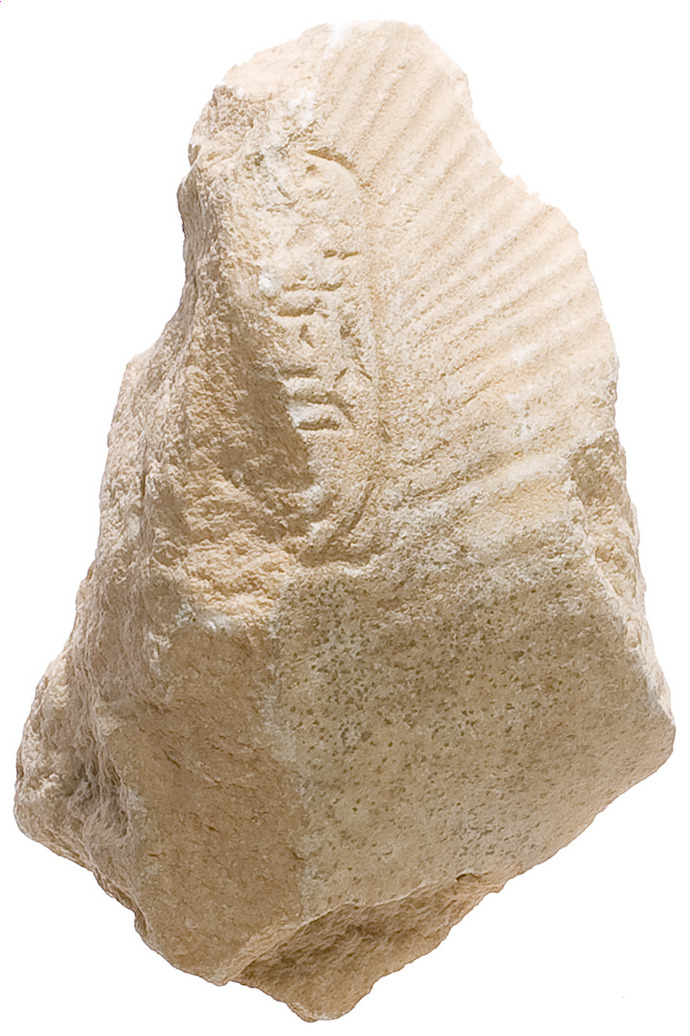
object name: breast, garment, aten cartouche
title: Breast with shawl, Aten cartouche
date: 1353-1336 BCE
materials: limestone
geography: egypt